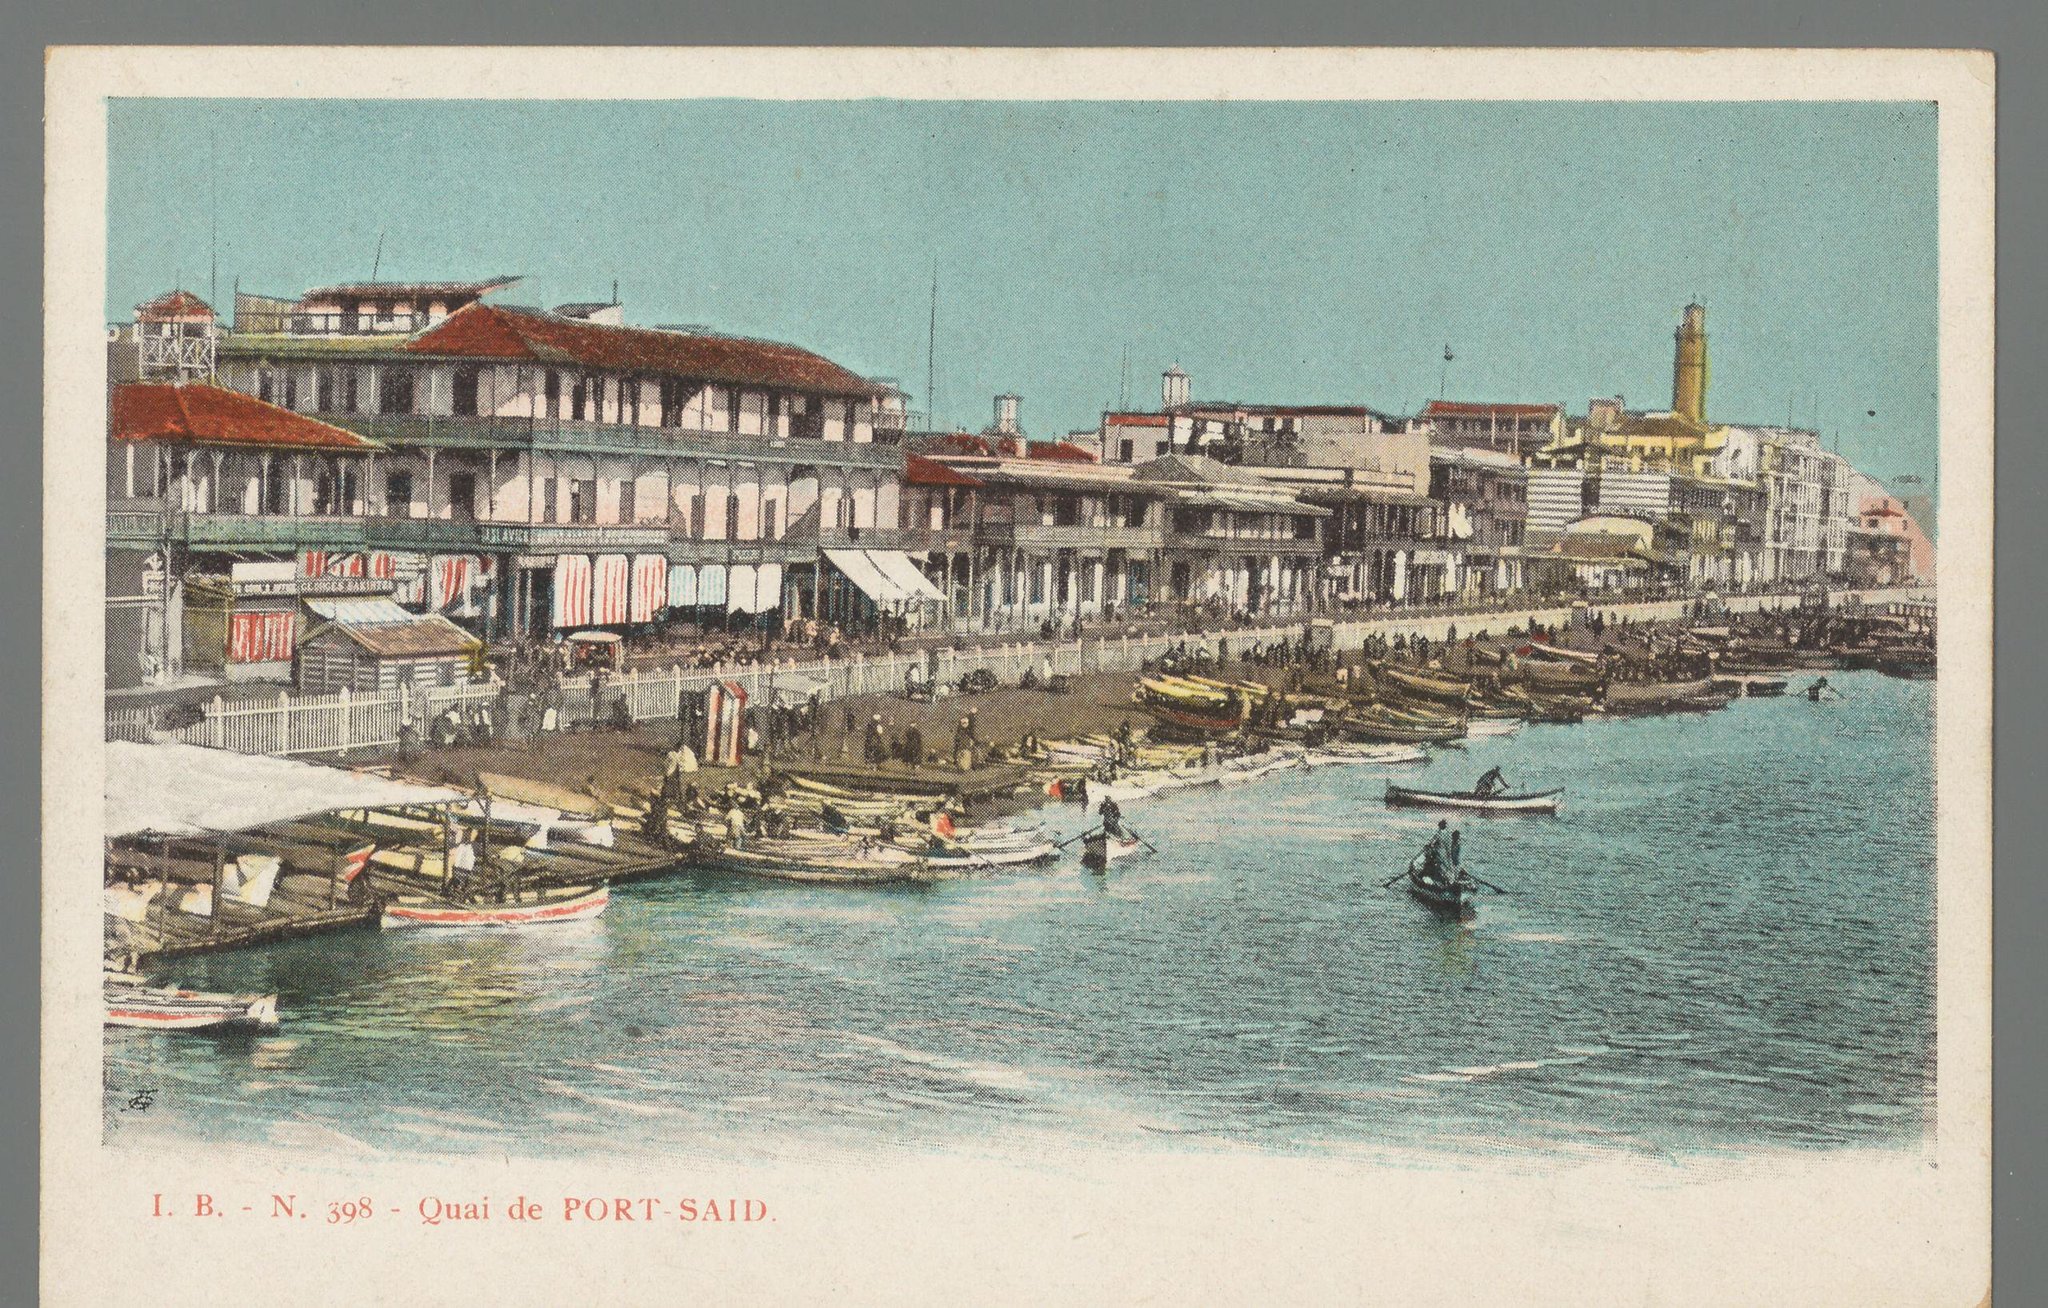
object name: ansichtkaart, prentbriefkaart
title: Quai de Port-Said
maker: Anonymous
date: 1907-1930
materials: cardboard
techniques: lithograph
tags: avenue, boulevard, promenade, esplanade, quay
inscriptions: inscription: ‘I. B. - N.’, monogram: ‘AG’